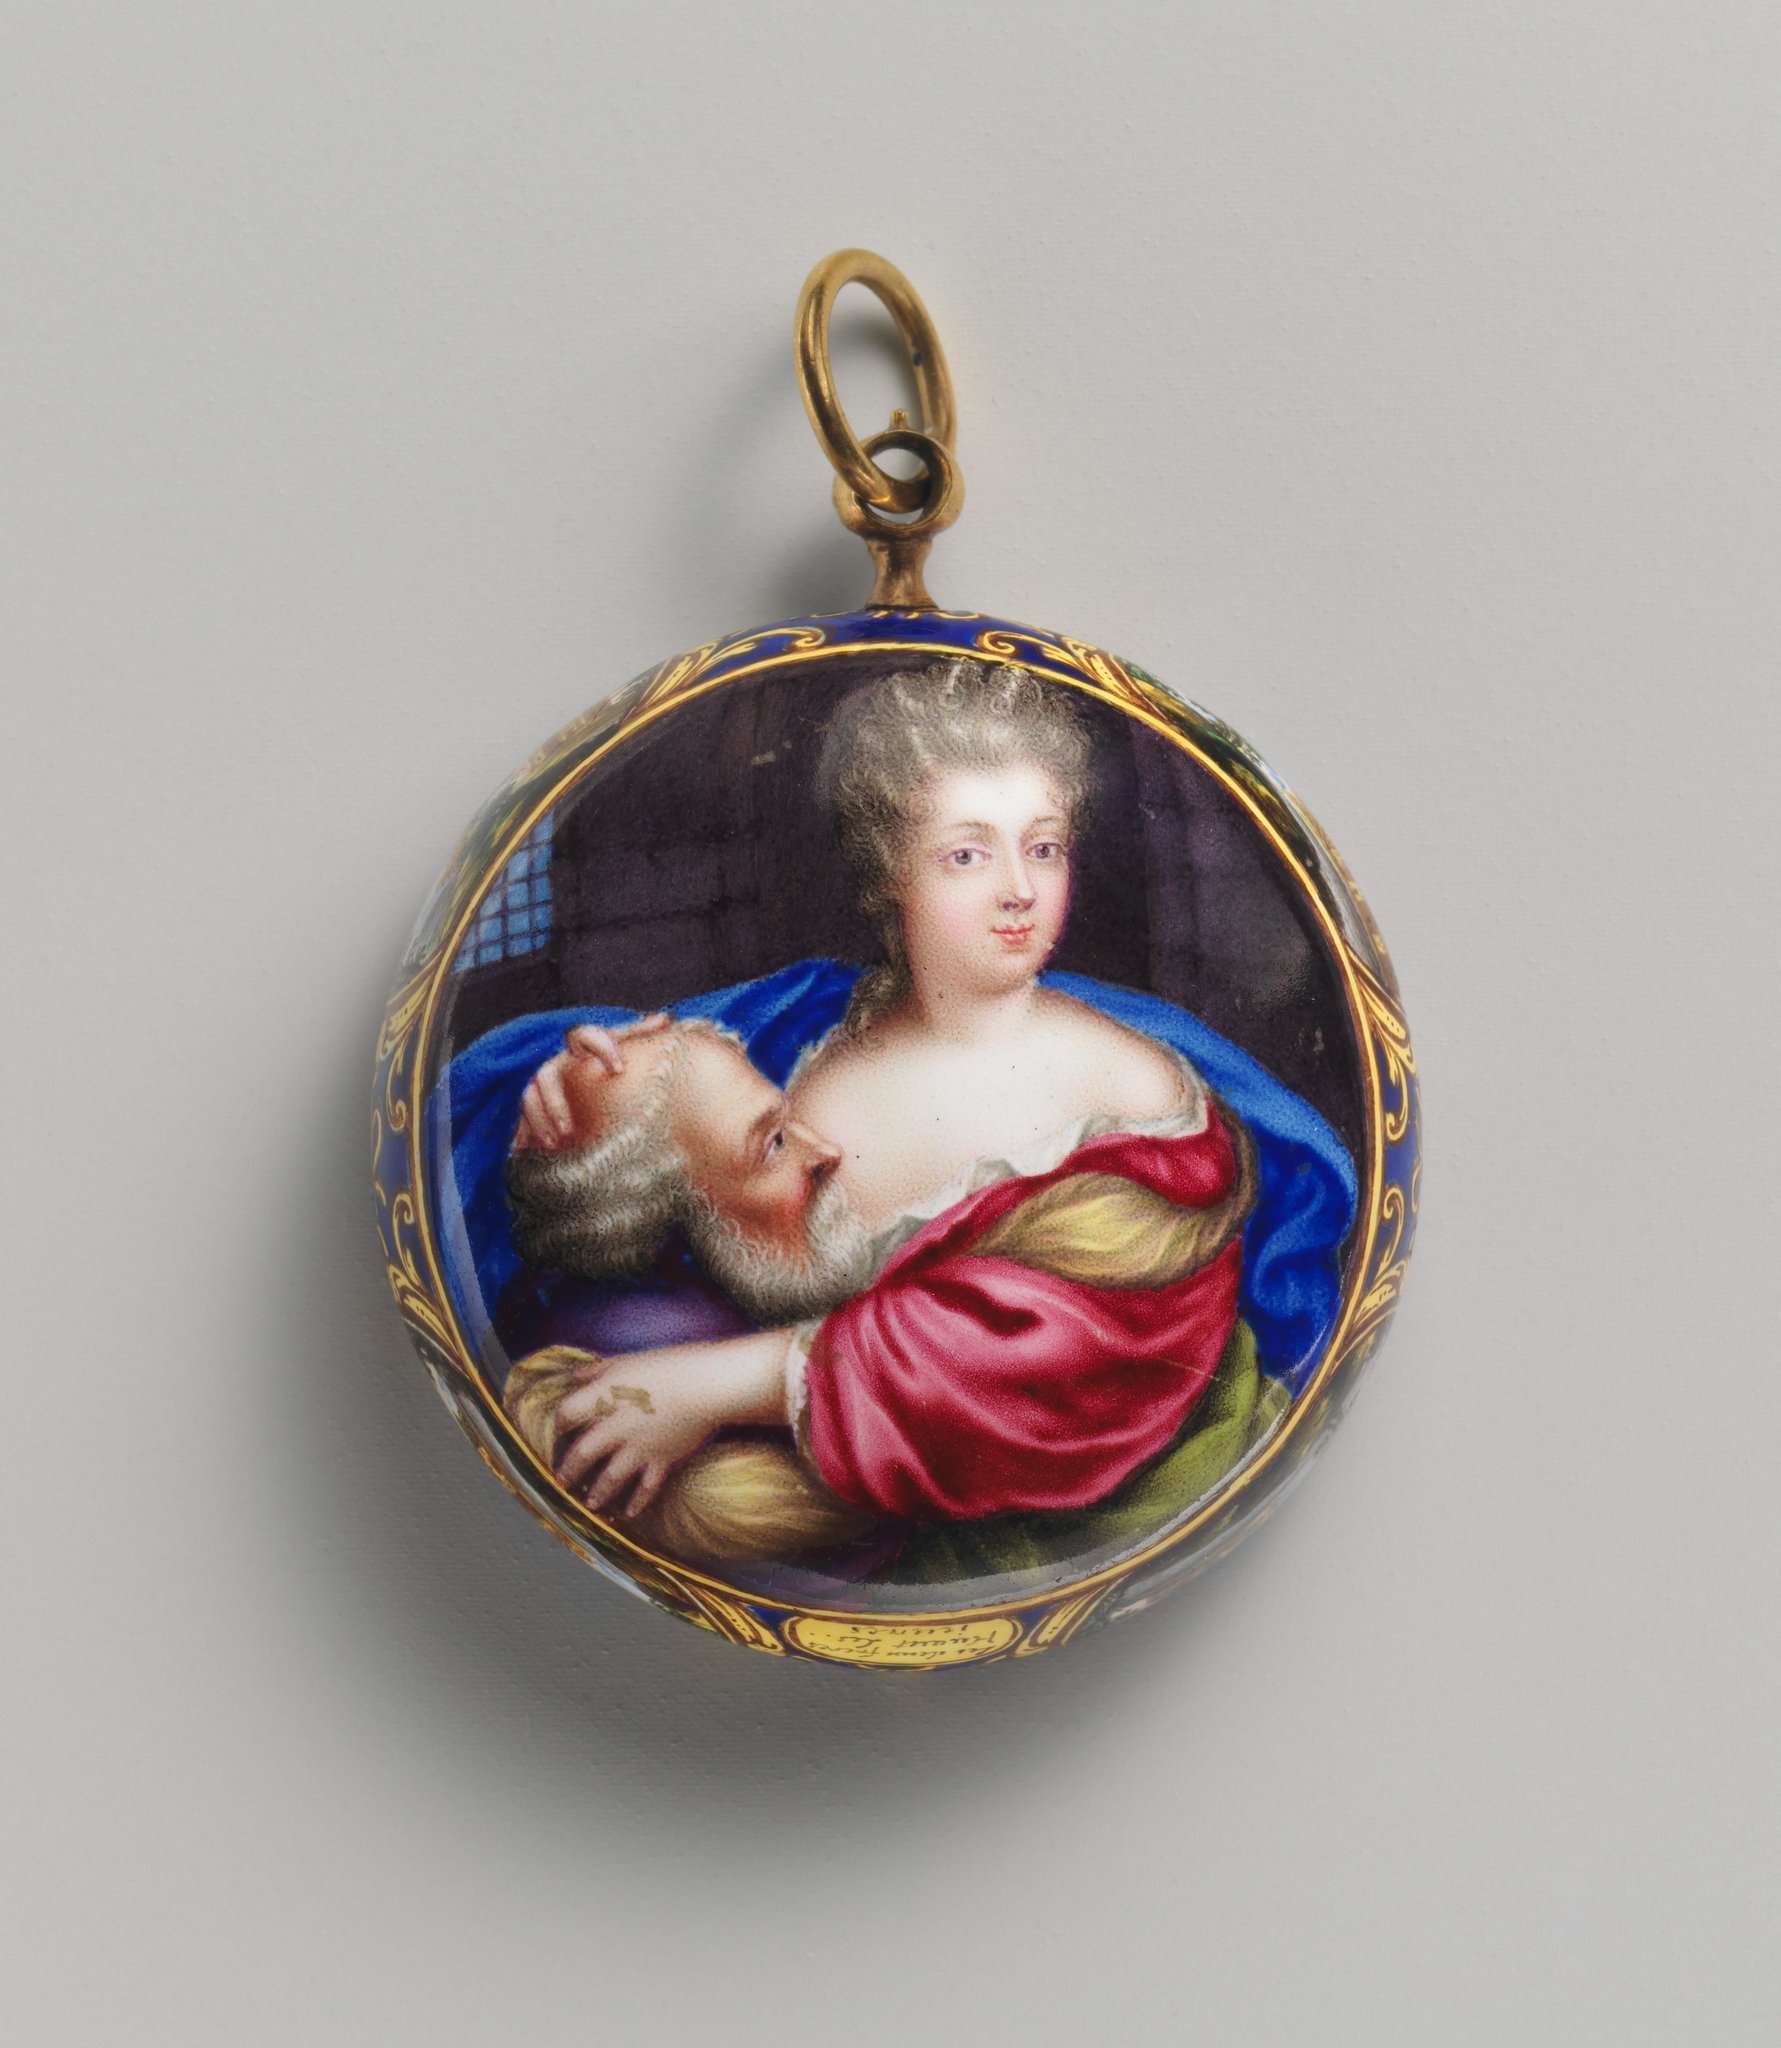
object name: watch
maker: pieter klock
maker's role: maker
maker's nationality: dutch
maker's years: 1665-1754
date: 1700-1710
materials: enamel, gold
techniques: painting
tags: men,women